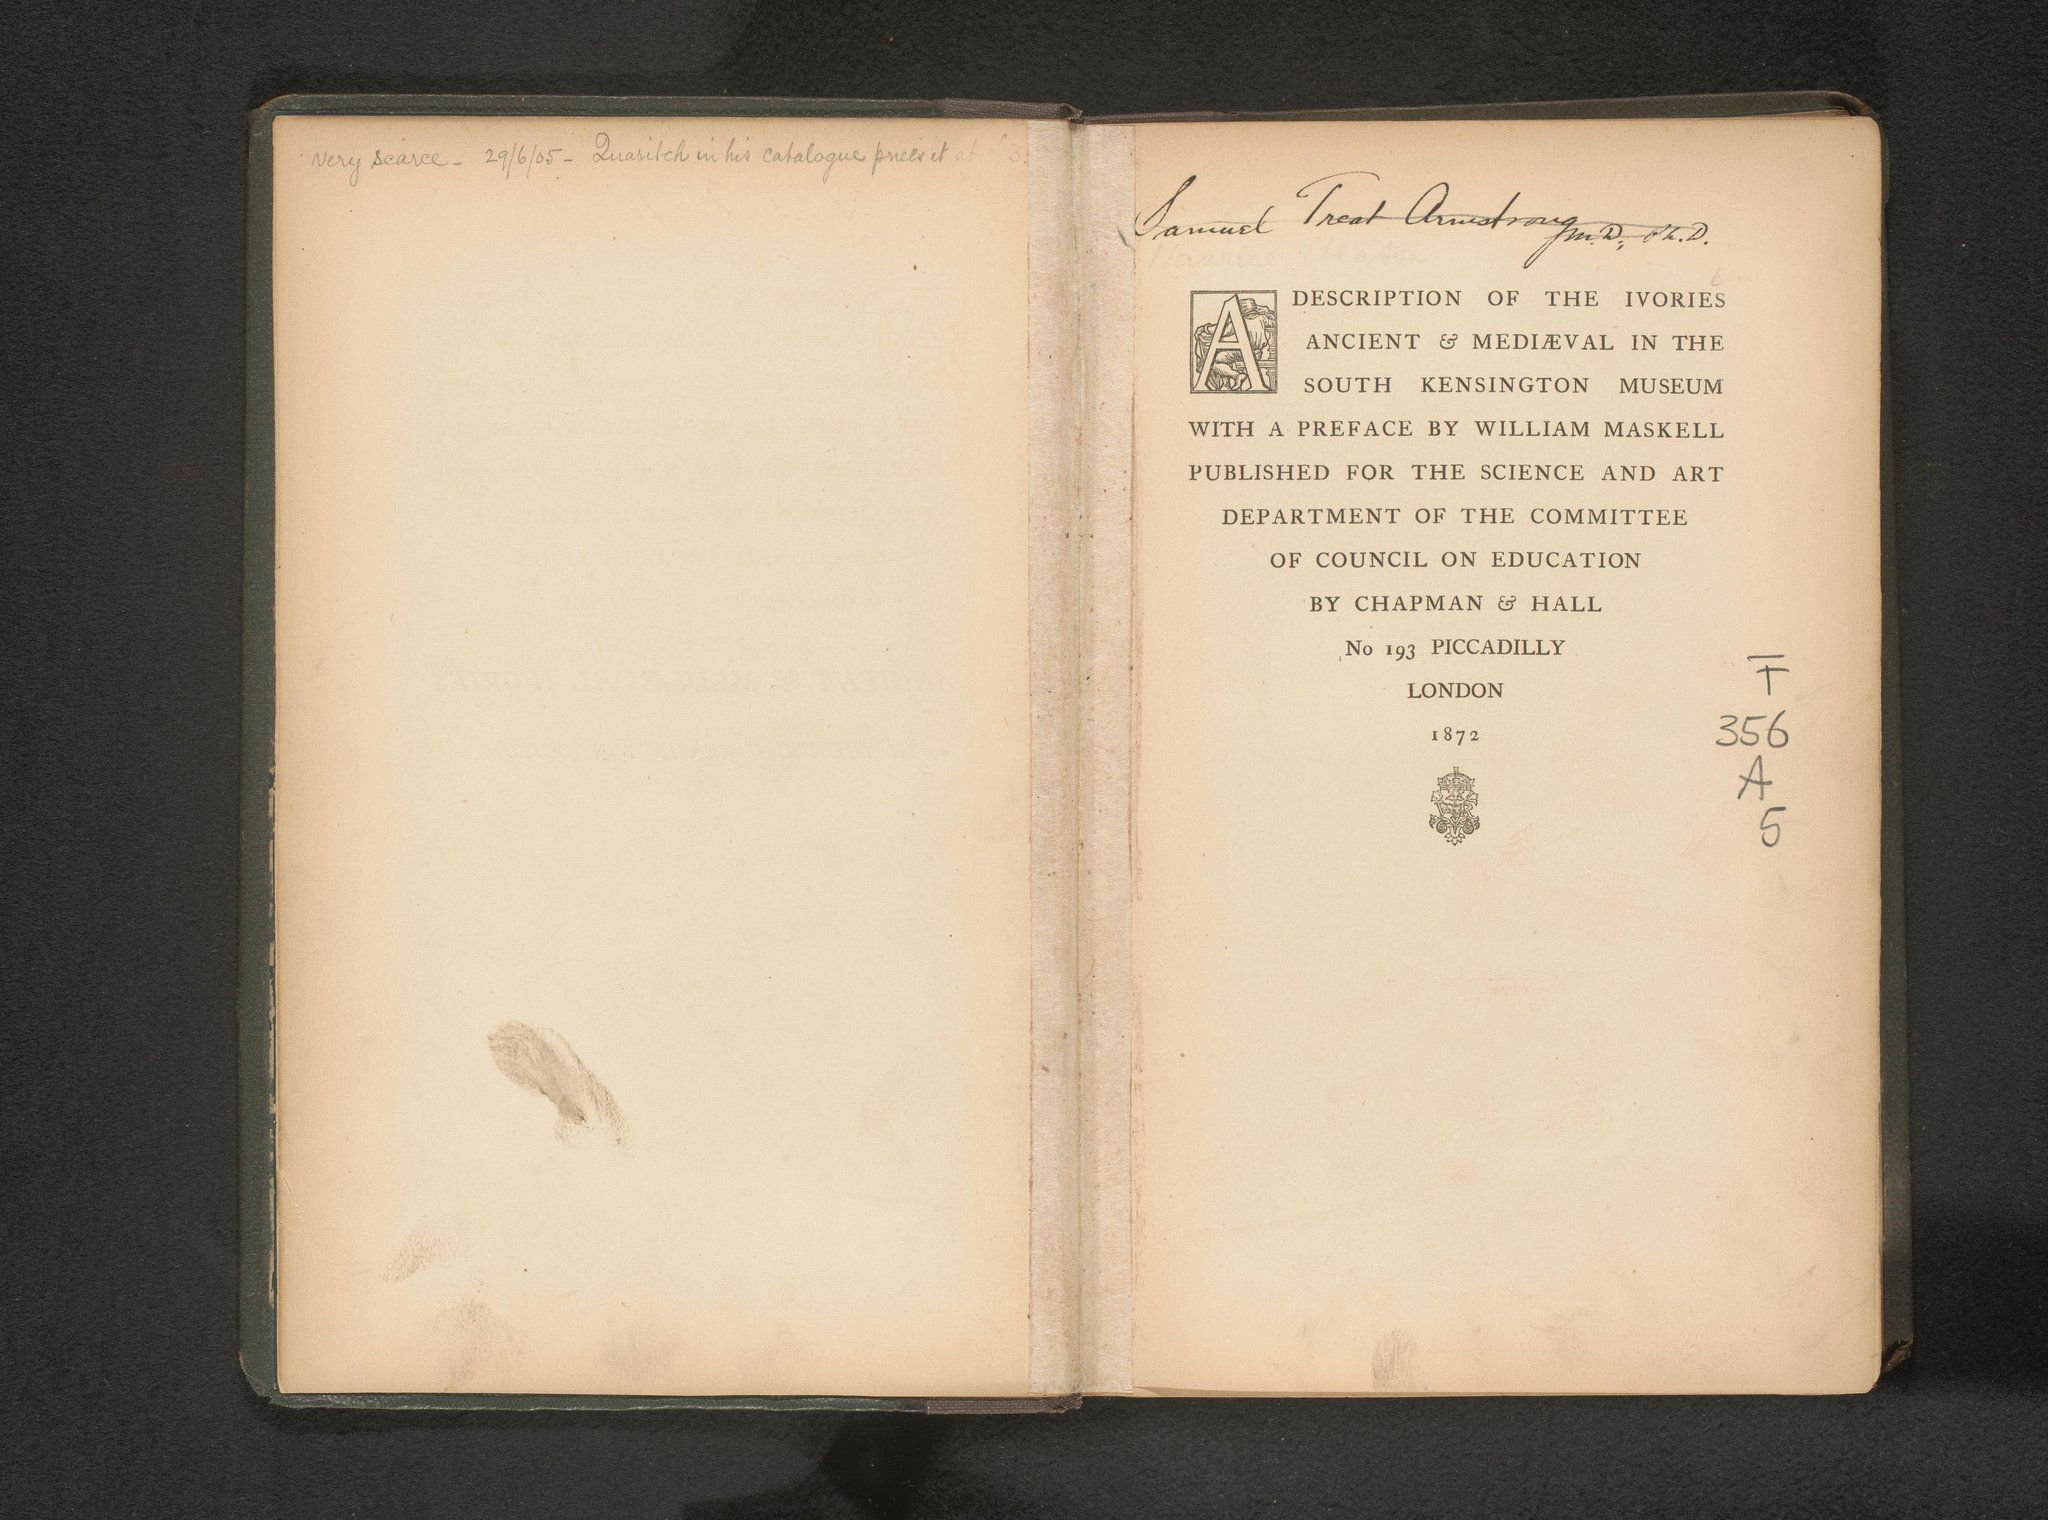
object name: book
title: A description of the ivories ancient and mediaeval in the South Kensington Museum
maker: william maskell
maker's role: clergyman, priest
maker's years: 1814-1890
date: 1872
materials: cardboard, leather, linen, paper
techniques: printing, woodburytype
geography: london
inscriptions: name: ‘Samuel Treat Armstrong M.D.Ph.D.’